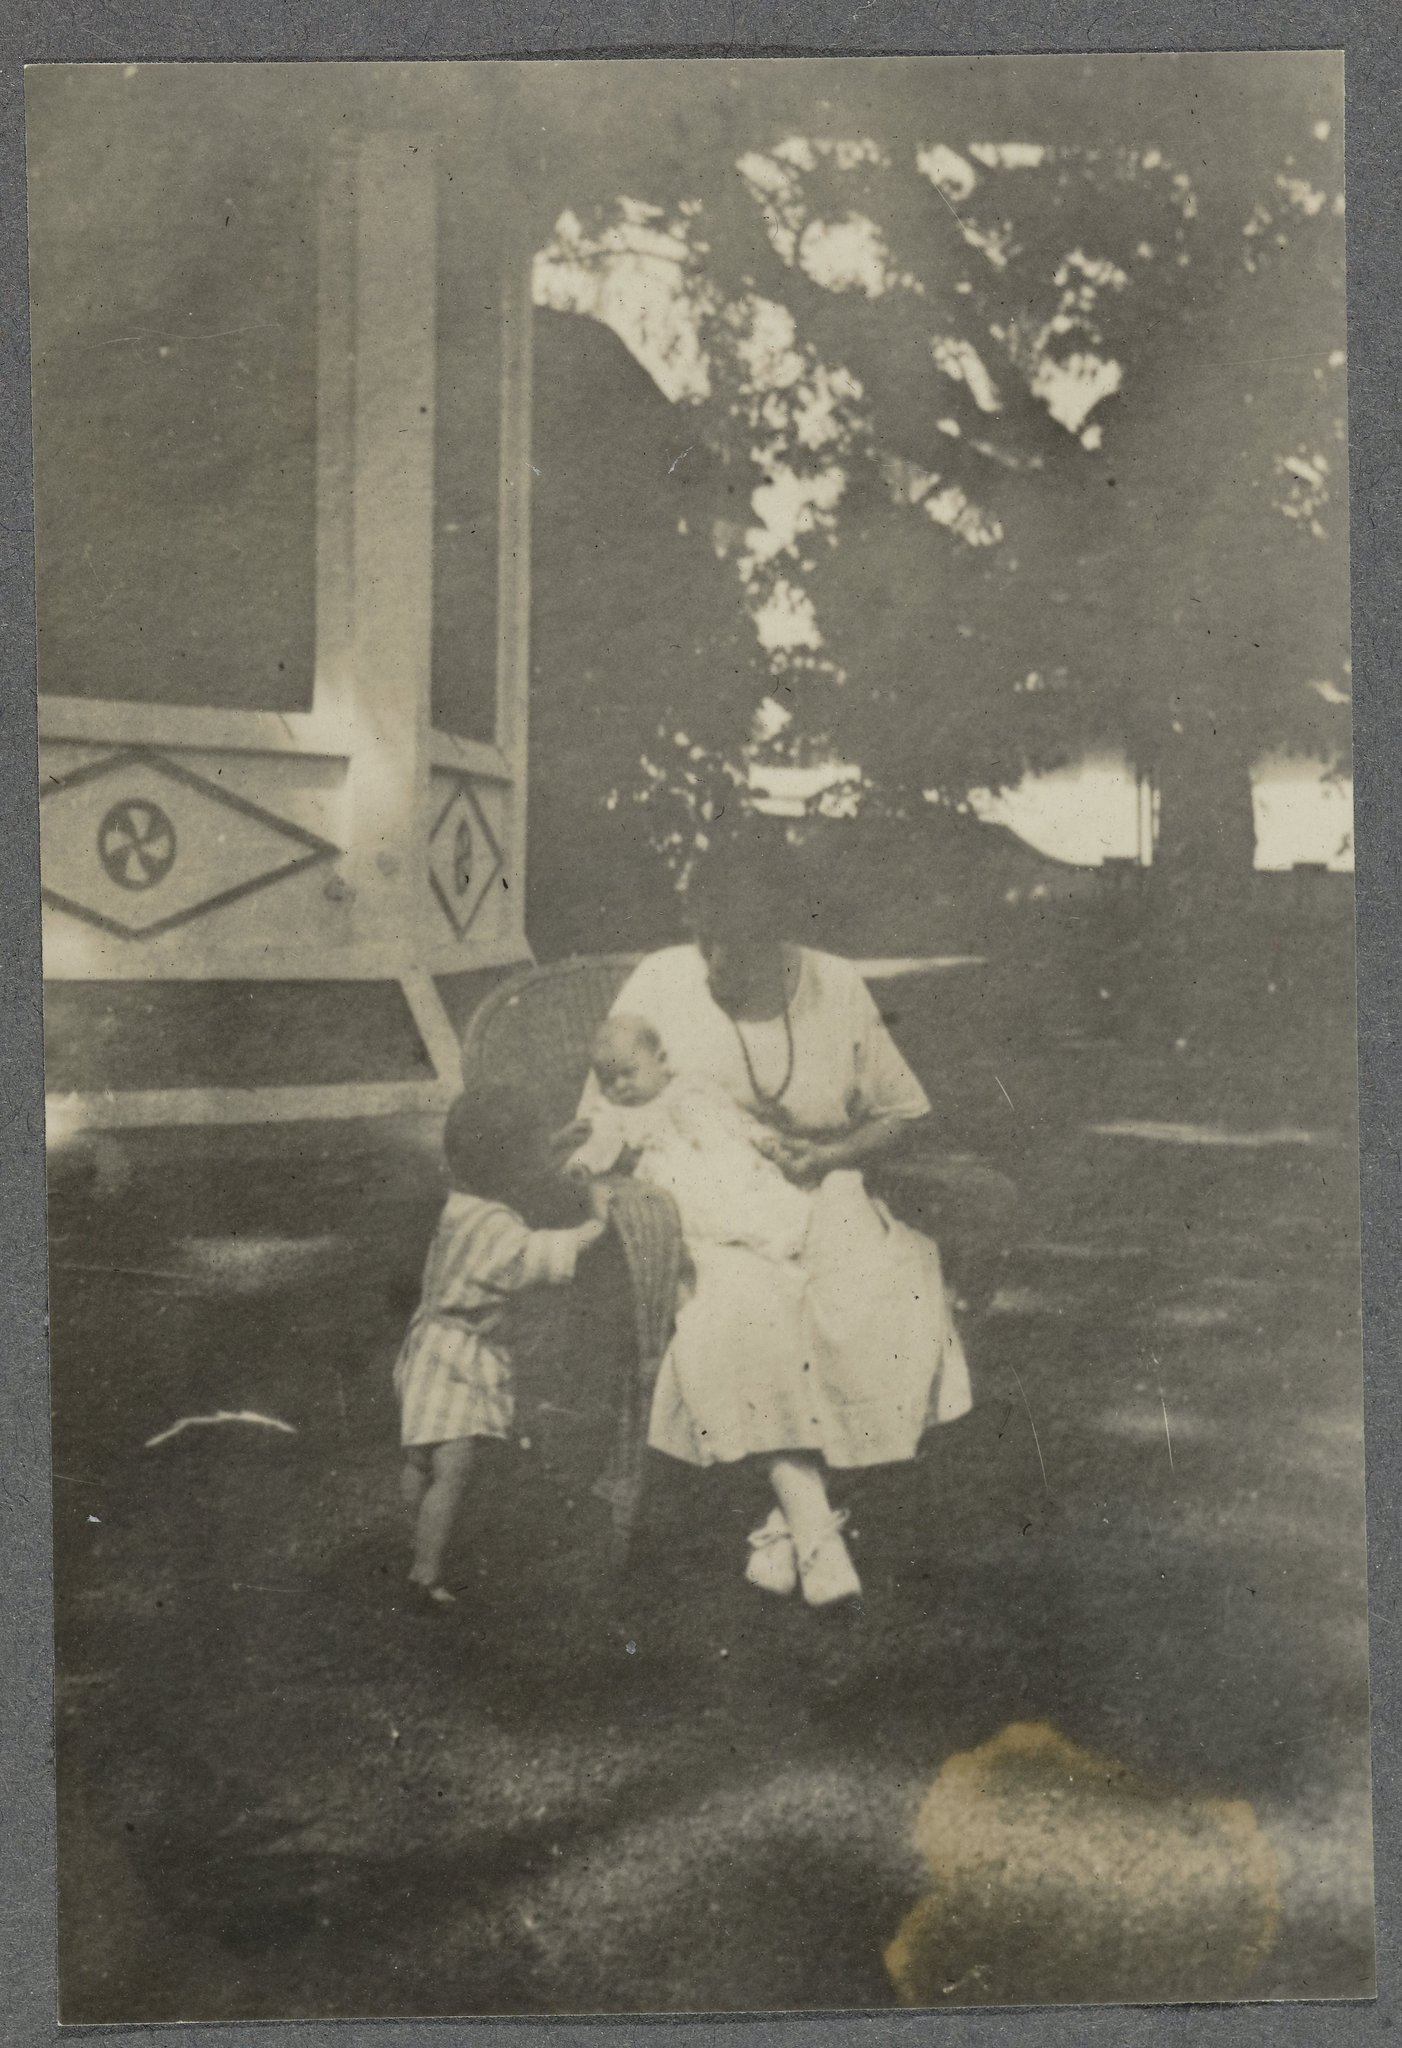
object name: photograph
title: Tine Kleiterp-Vermeulen en (vermoedelijk) haar kinderen Klaas en Tiny in een tuin in Pangka op Java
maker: klaas kleiterp (i)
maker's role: arts, officier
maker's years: 1892-1943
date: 1921-1922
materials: paper, photographic support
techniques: daylight paper print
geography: pangka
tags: garden, mother and baby or young child, dutch east indies, the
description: Onderdeel van Fotoalbum van de familie Kleiterp-Vermeulen met opnames van de kinderen Klaas en Tiny in Nederlands-Indië.